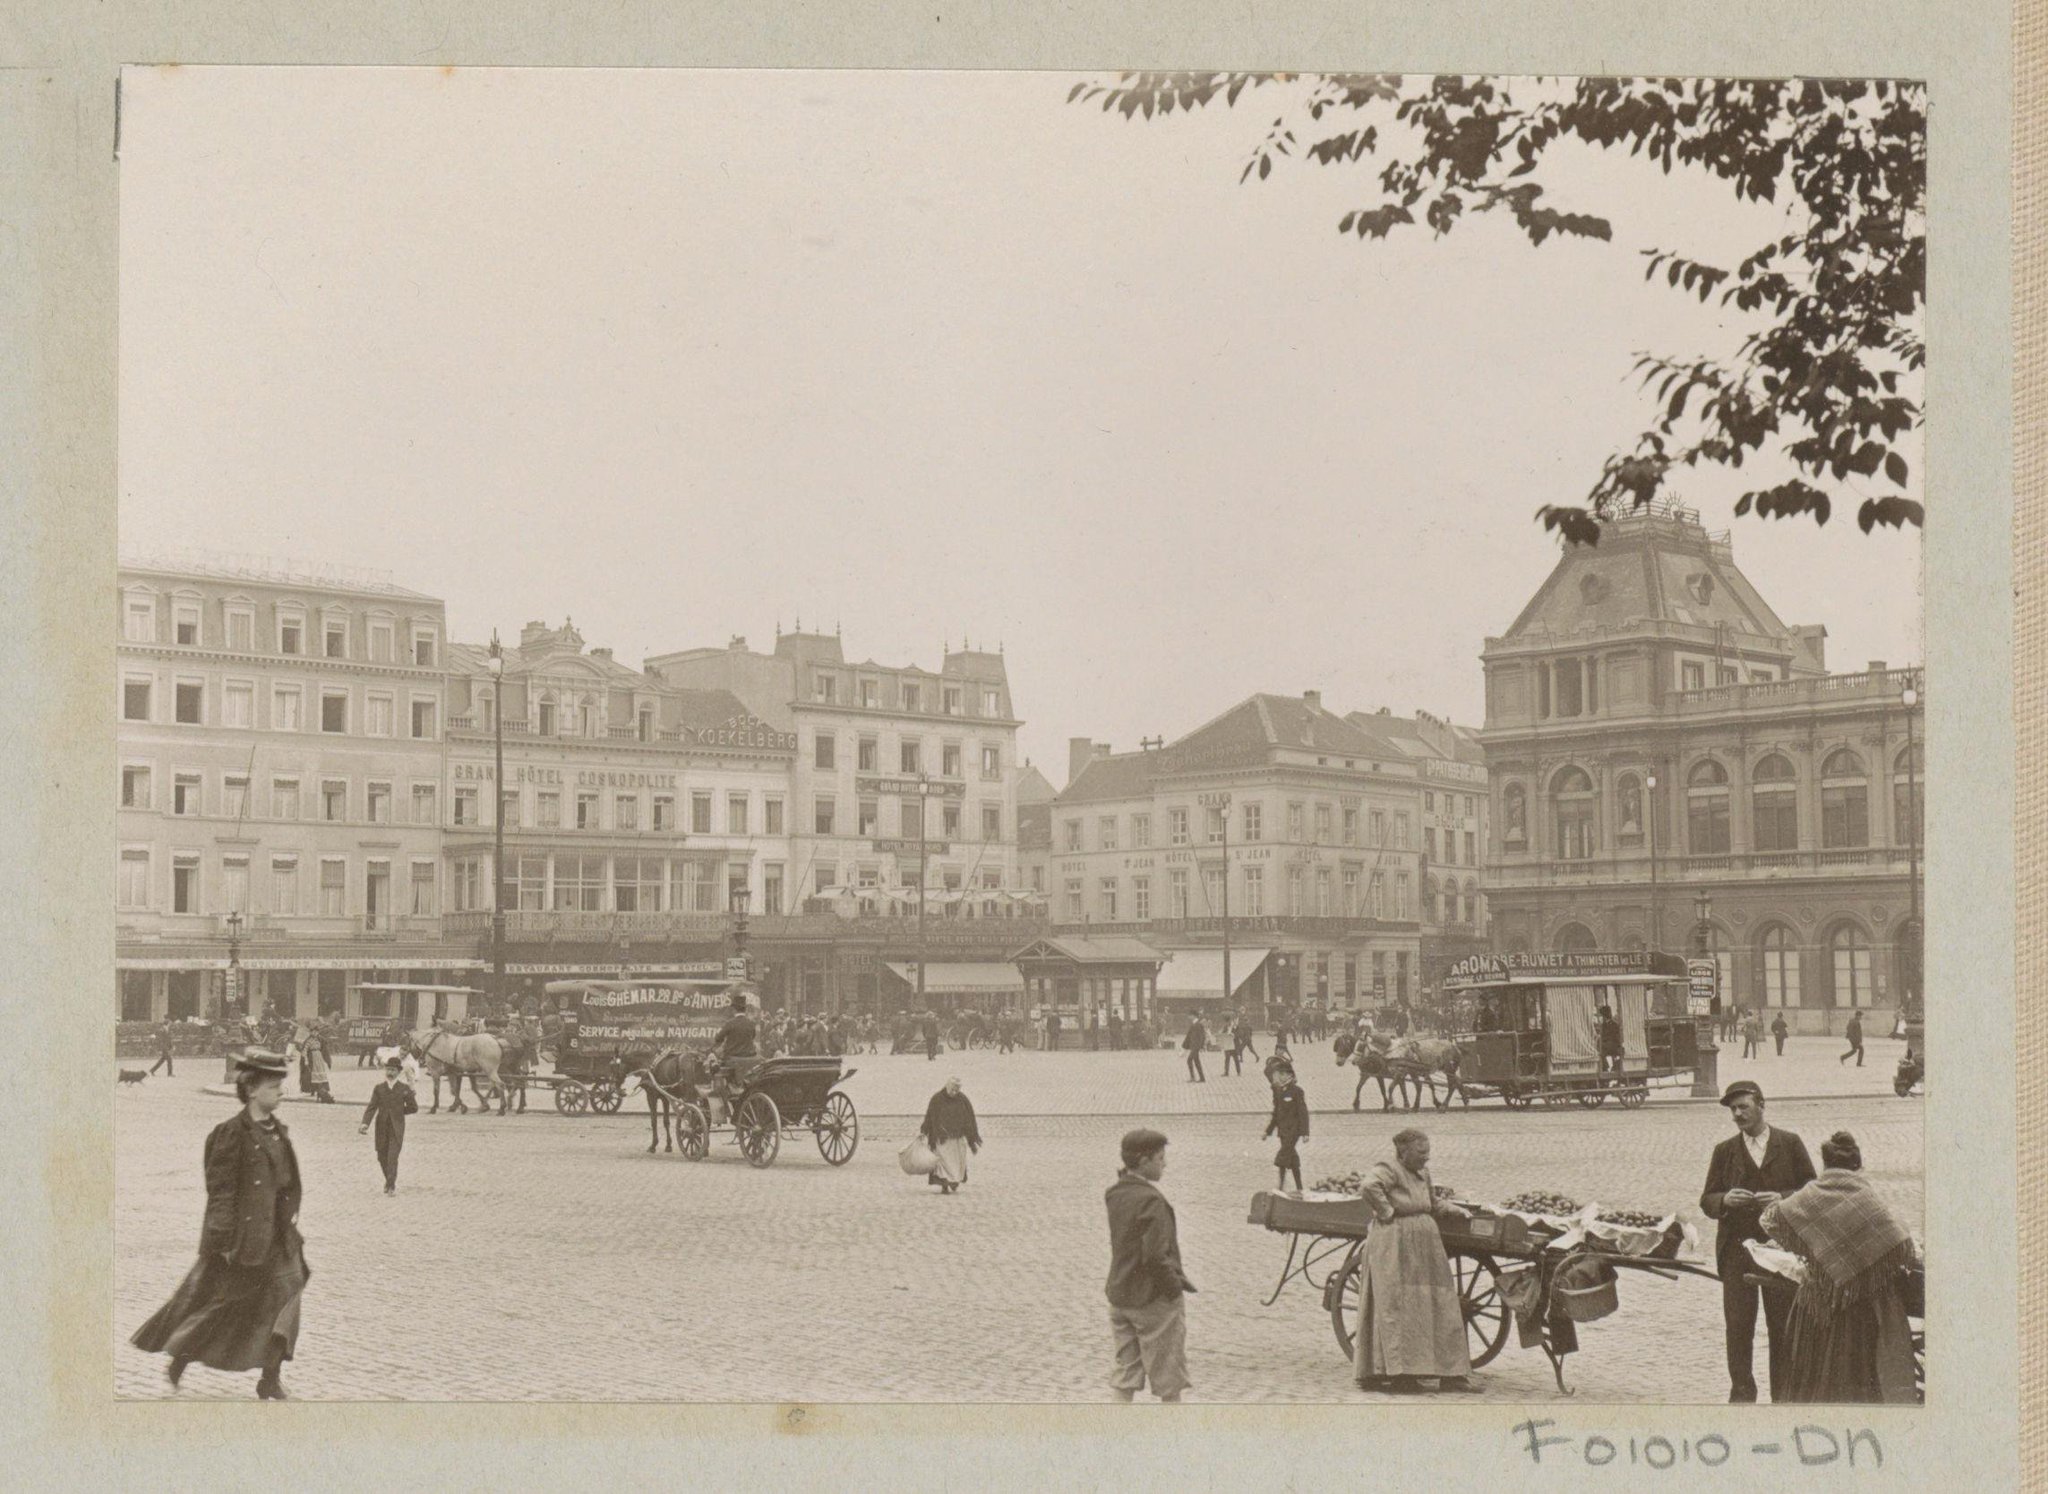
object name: photograph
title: Rogierplein te Brussel: bebouwing, voorbijgangers, paardenkoetsen en een mosselvrouw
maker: Anonymous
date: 1900-1910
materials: photographic support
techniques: matte daylight collodion silver print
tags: four-wheeled, animal-drawn vehicle, e.g.: cab, carriage, coach (+ conveyance for transport of persons), hand-cart (+ variant), market, hotel, hostelry, inn, square, place, circus, etc. (+ city(-scape) with figures, staffage)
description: Onderdeel van Familiealbum met onder meer foto's van Wijnhandel Kraaij & Co. Bordeaux-Amsterdam.